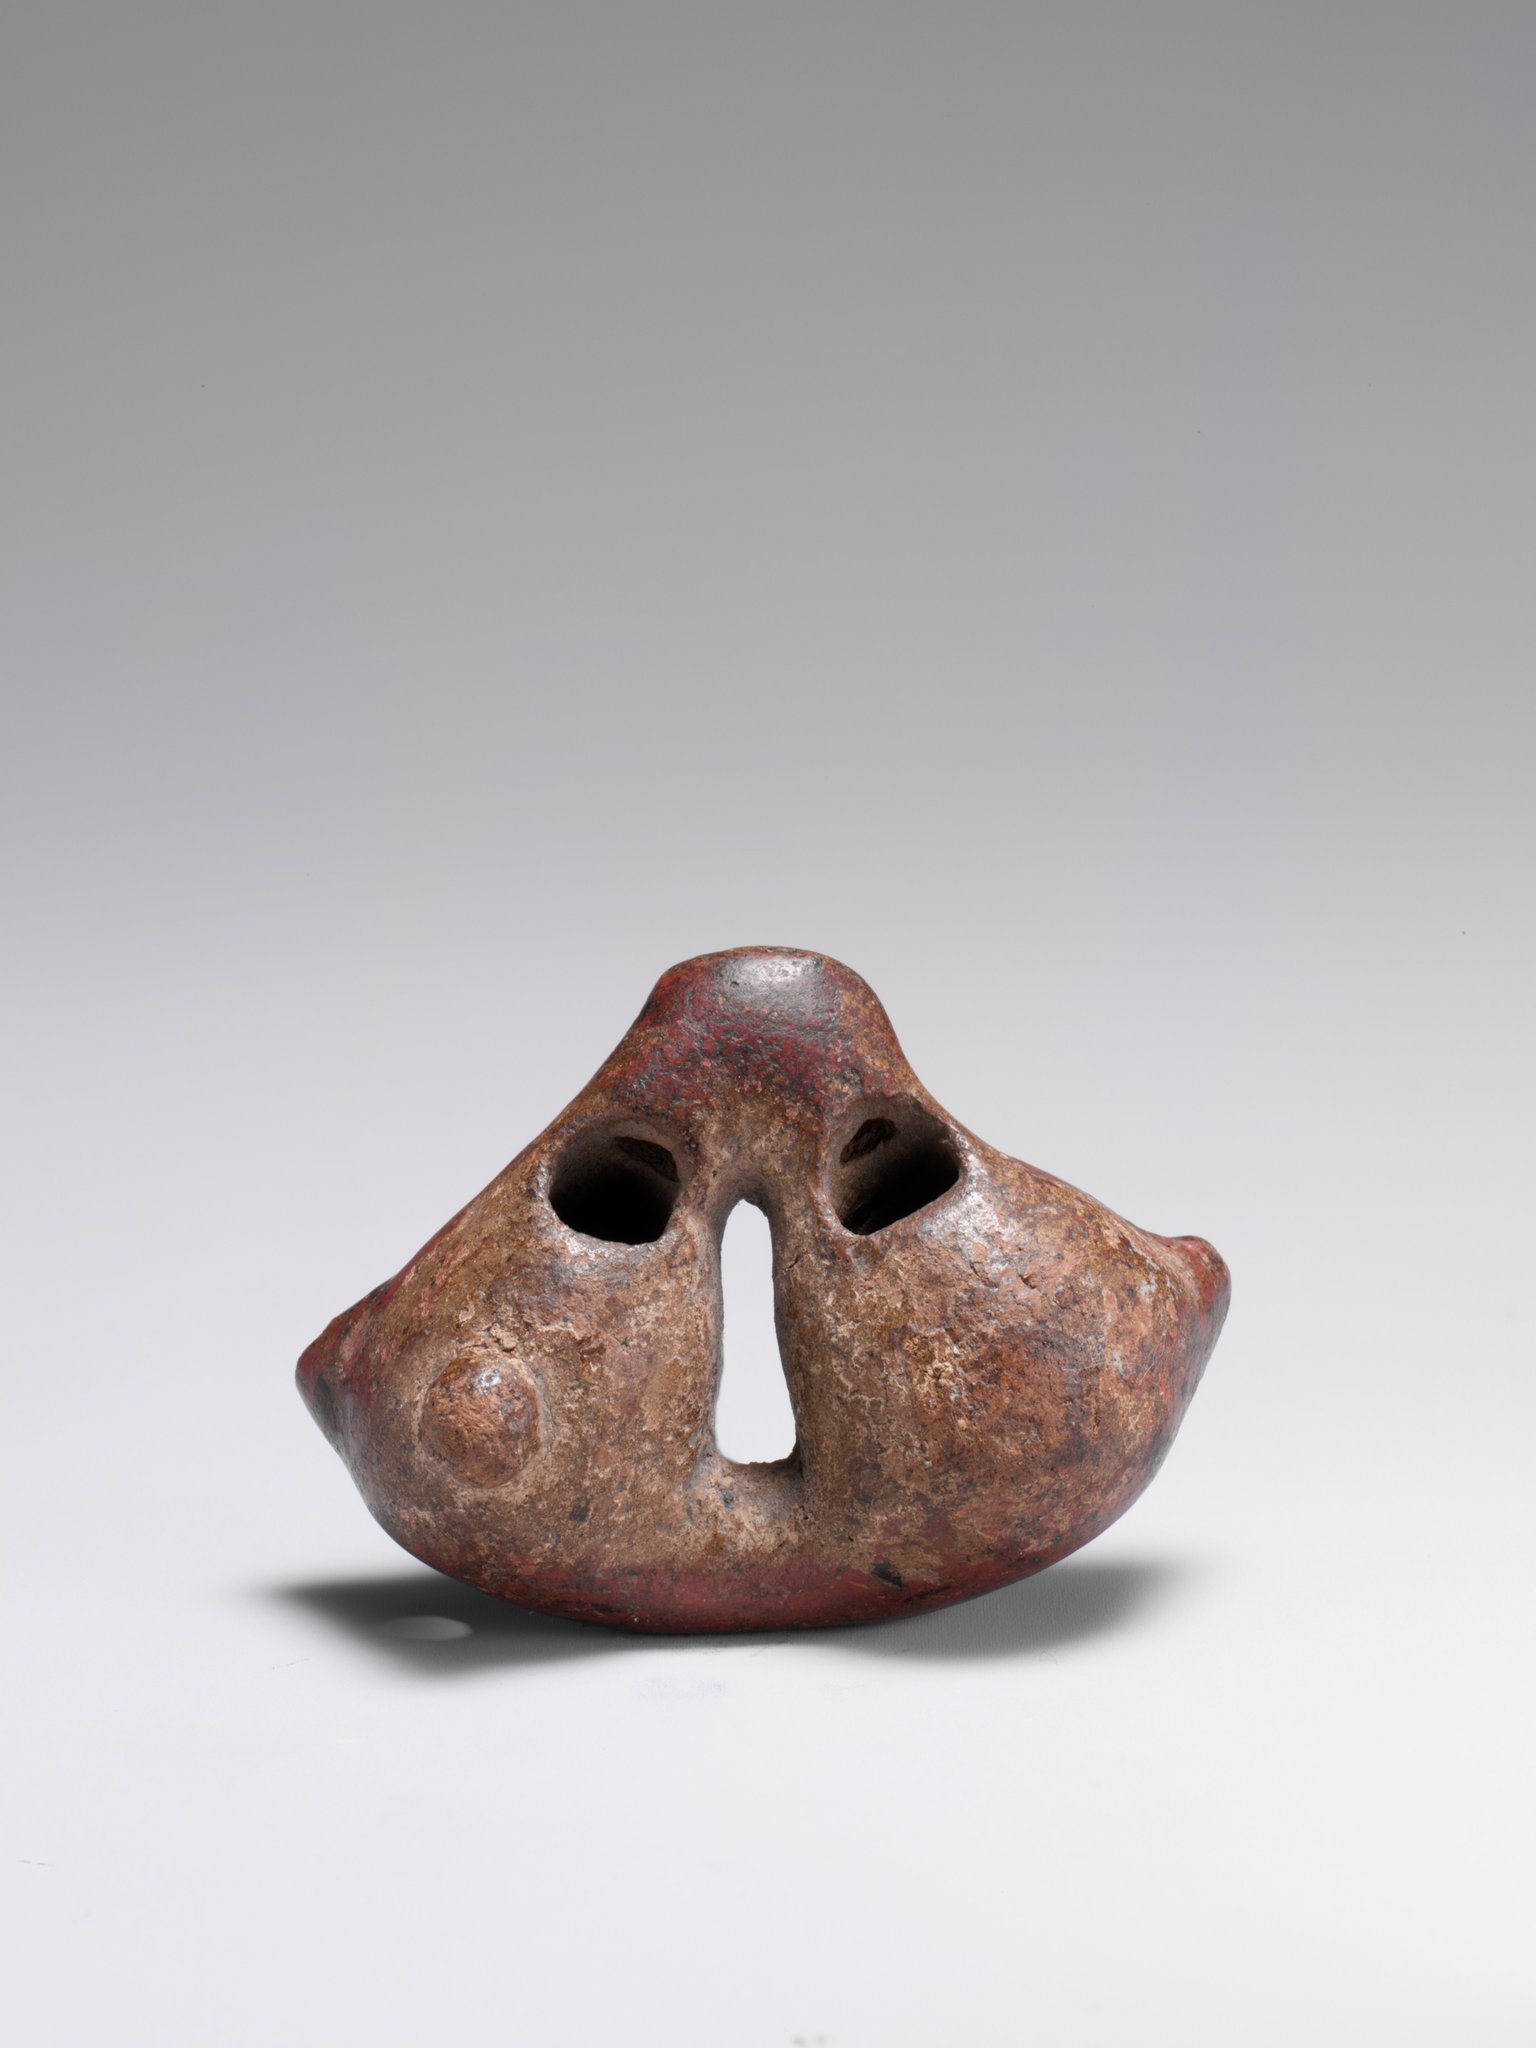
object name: pottery whistle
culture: costa rican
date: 800-1525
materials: clay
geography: costa rica